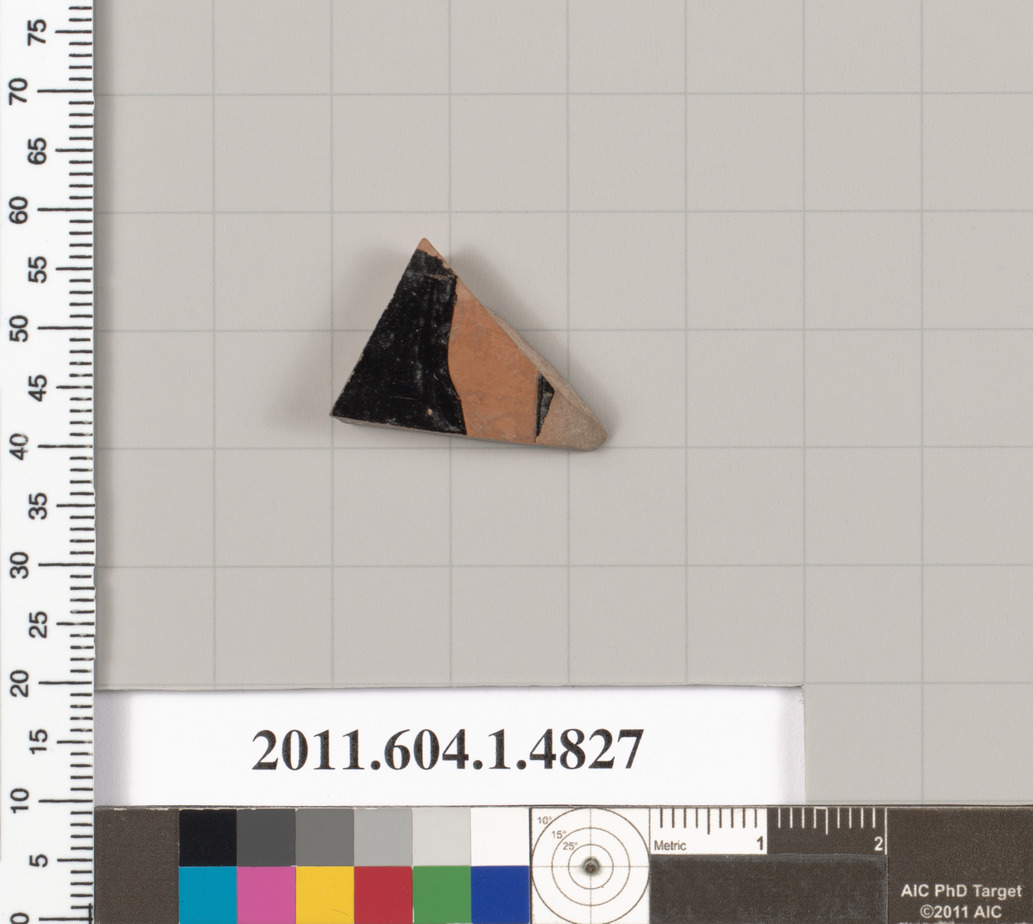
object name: kylix fragment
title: Terracotta fragment of a kylix (drinking cup)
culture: greek, attic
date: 490-470 BCE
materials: terracotta